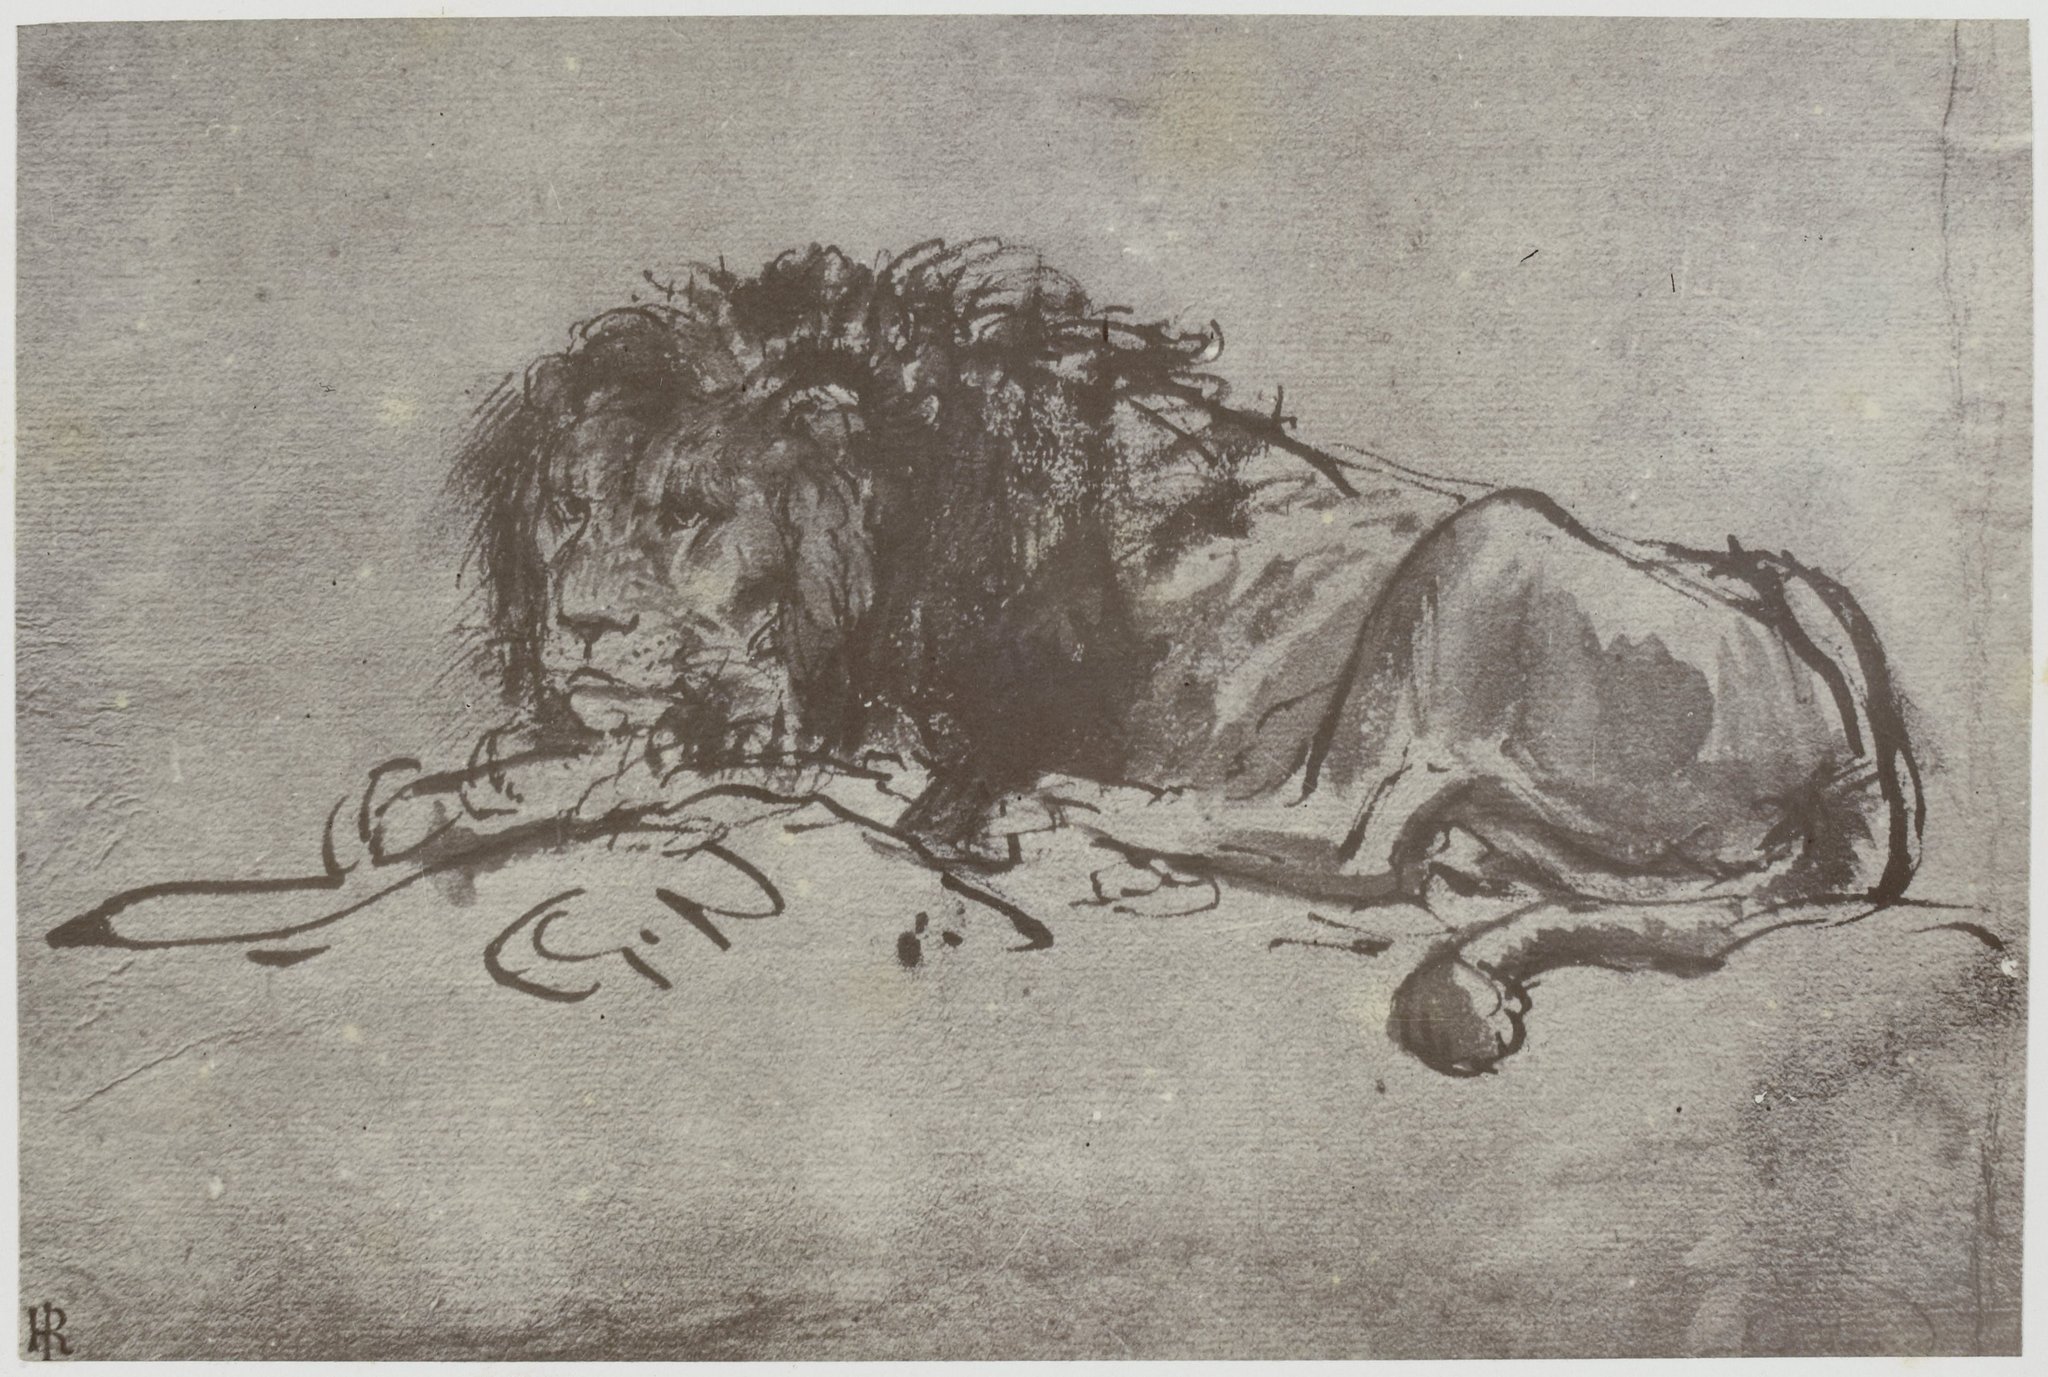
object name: photograph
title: Rembrandt, A Lion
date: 1855-1858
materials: cardboard, paper, photographic support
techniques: albumen print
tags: leiden, amsterdam, print maker, rembrandt van rijn, drawing, sketch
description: Fotoreproductie van tekening in 'The Reveley Collection of Drawings at Brynygwin', afb. 42.